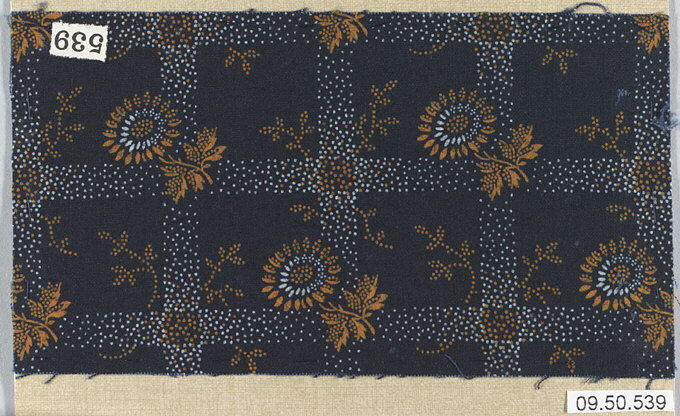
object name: piece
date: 1801-1900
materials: cotton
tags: flowers,leaves